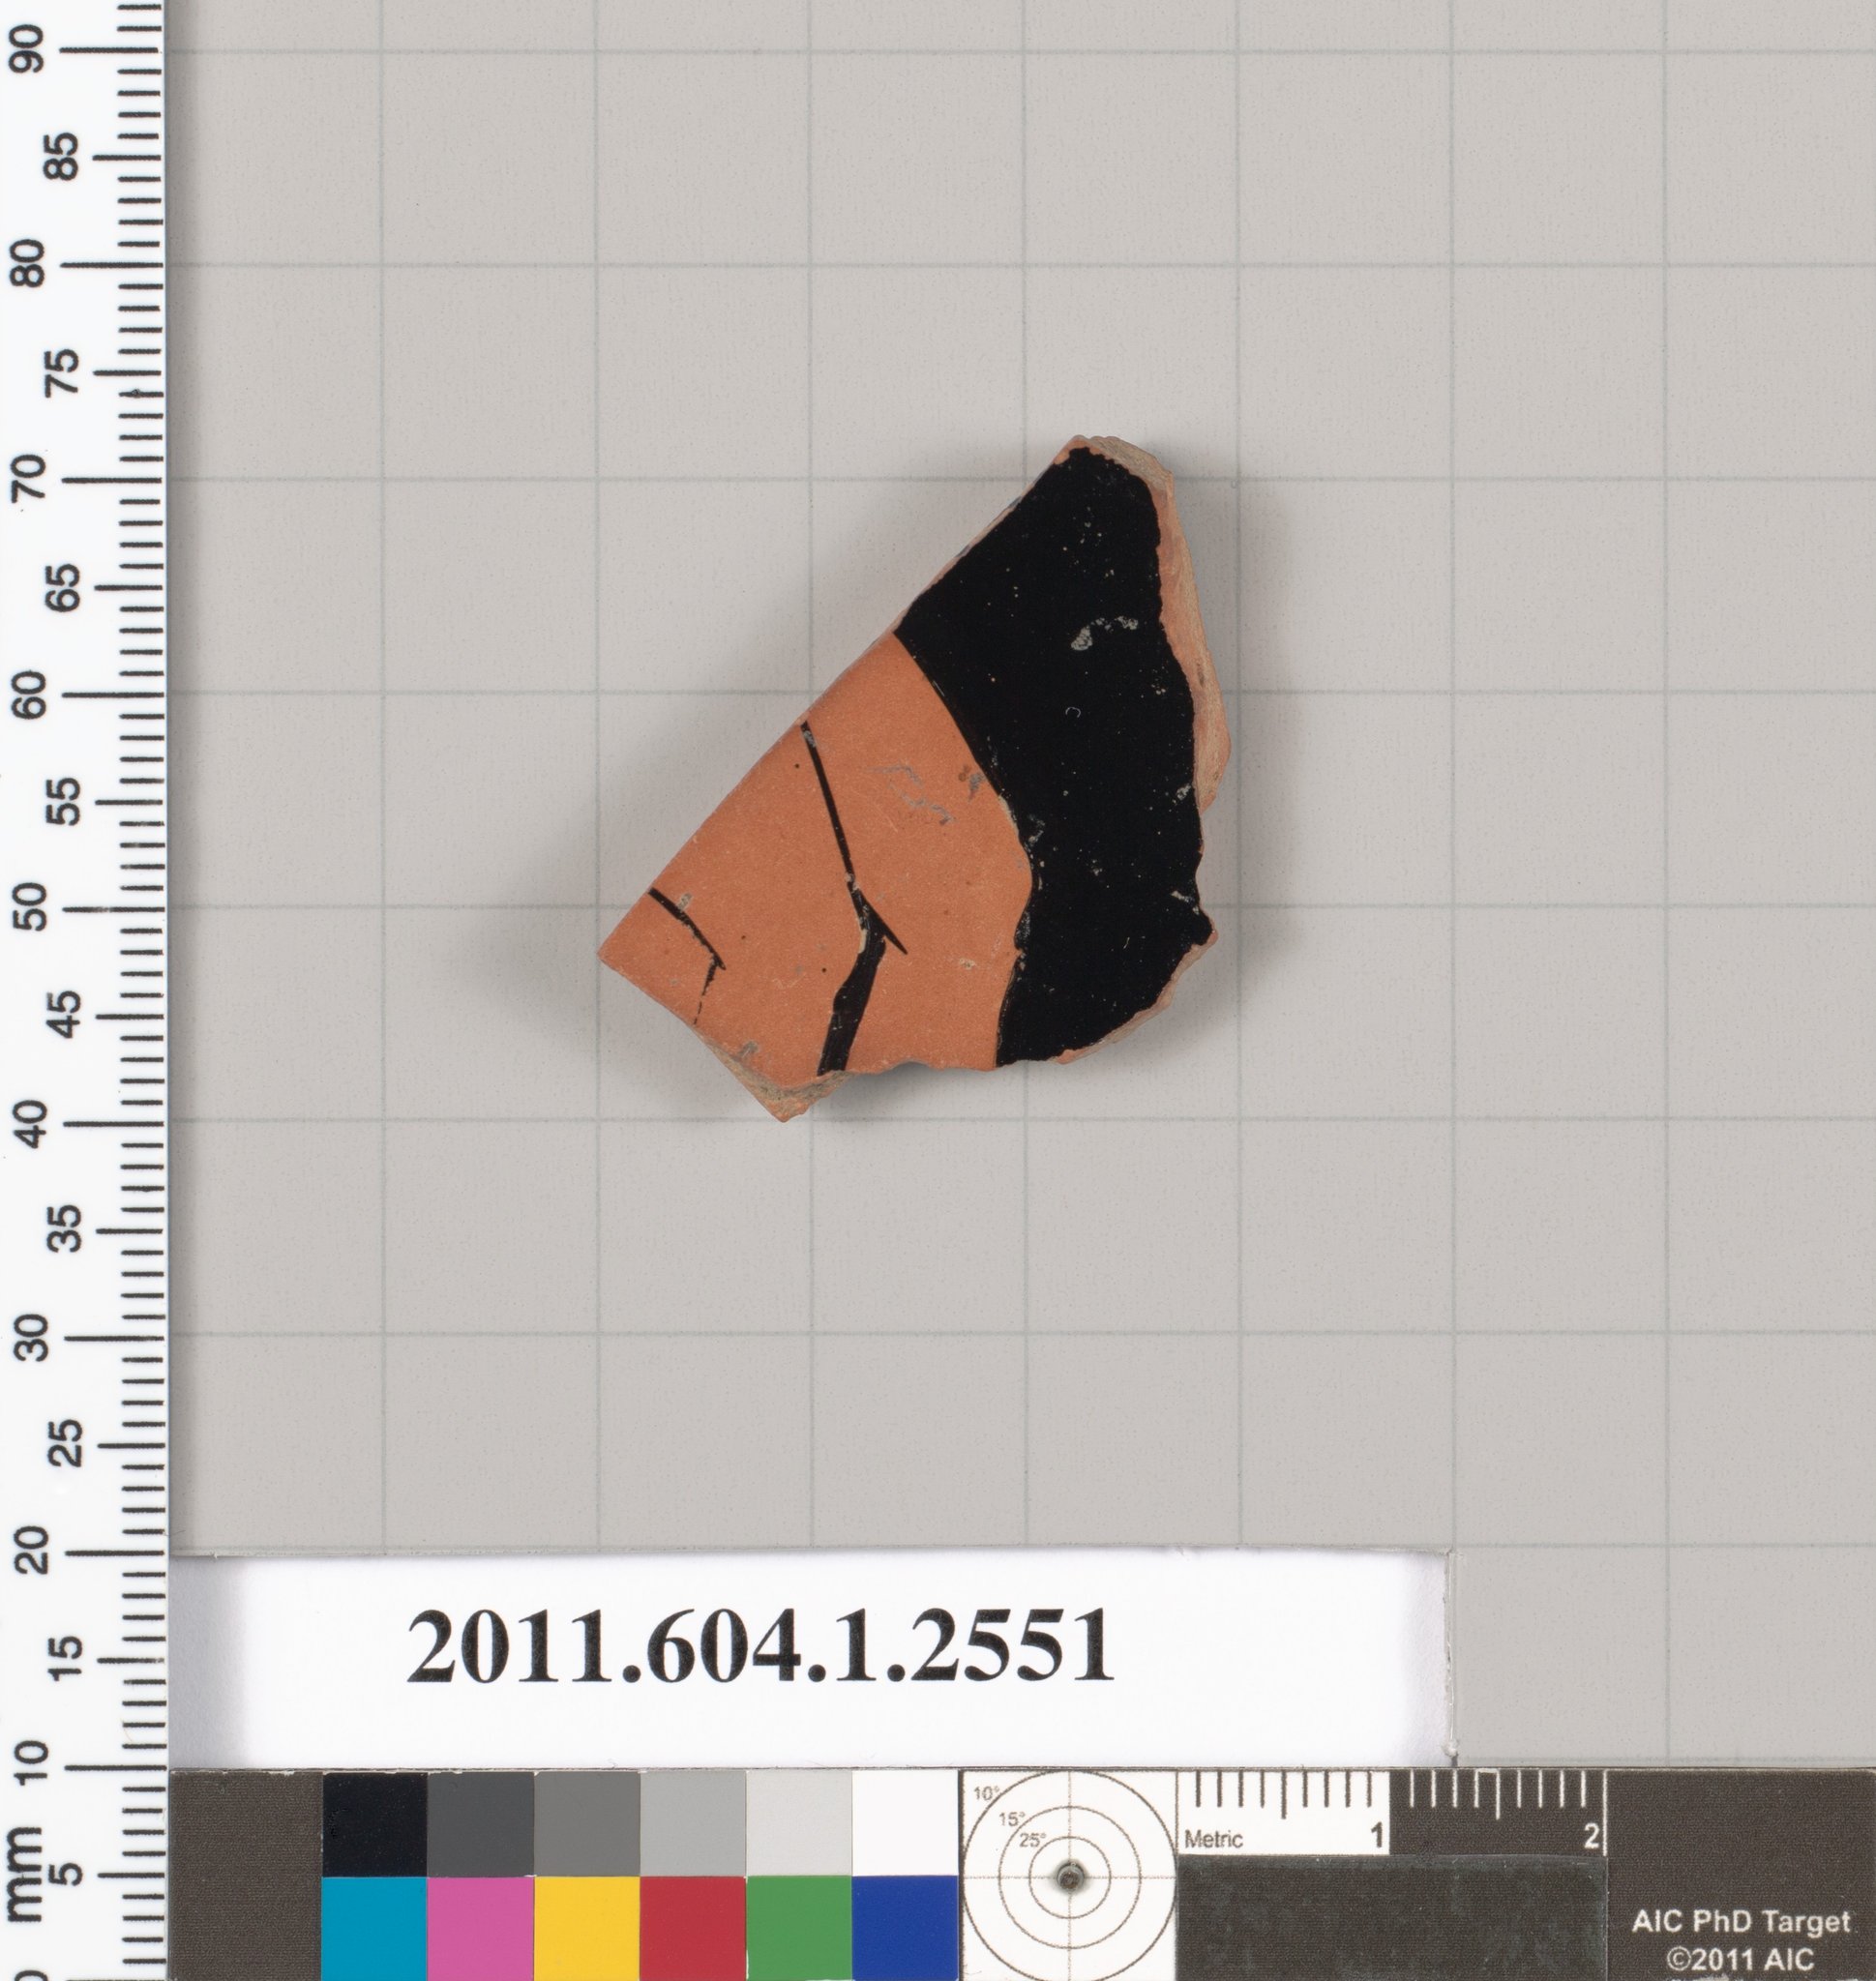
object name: kylix fragment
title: Terracotta fragment of a kylix (drinking cup)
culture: greek, attic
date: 490-480 BCE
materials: terracotta